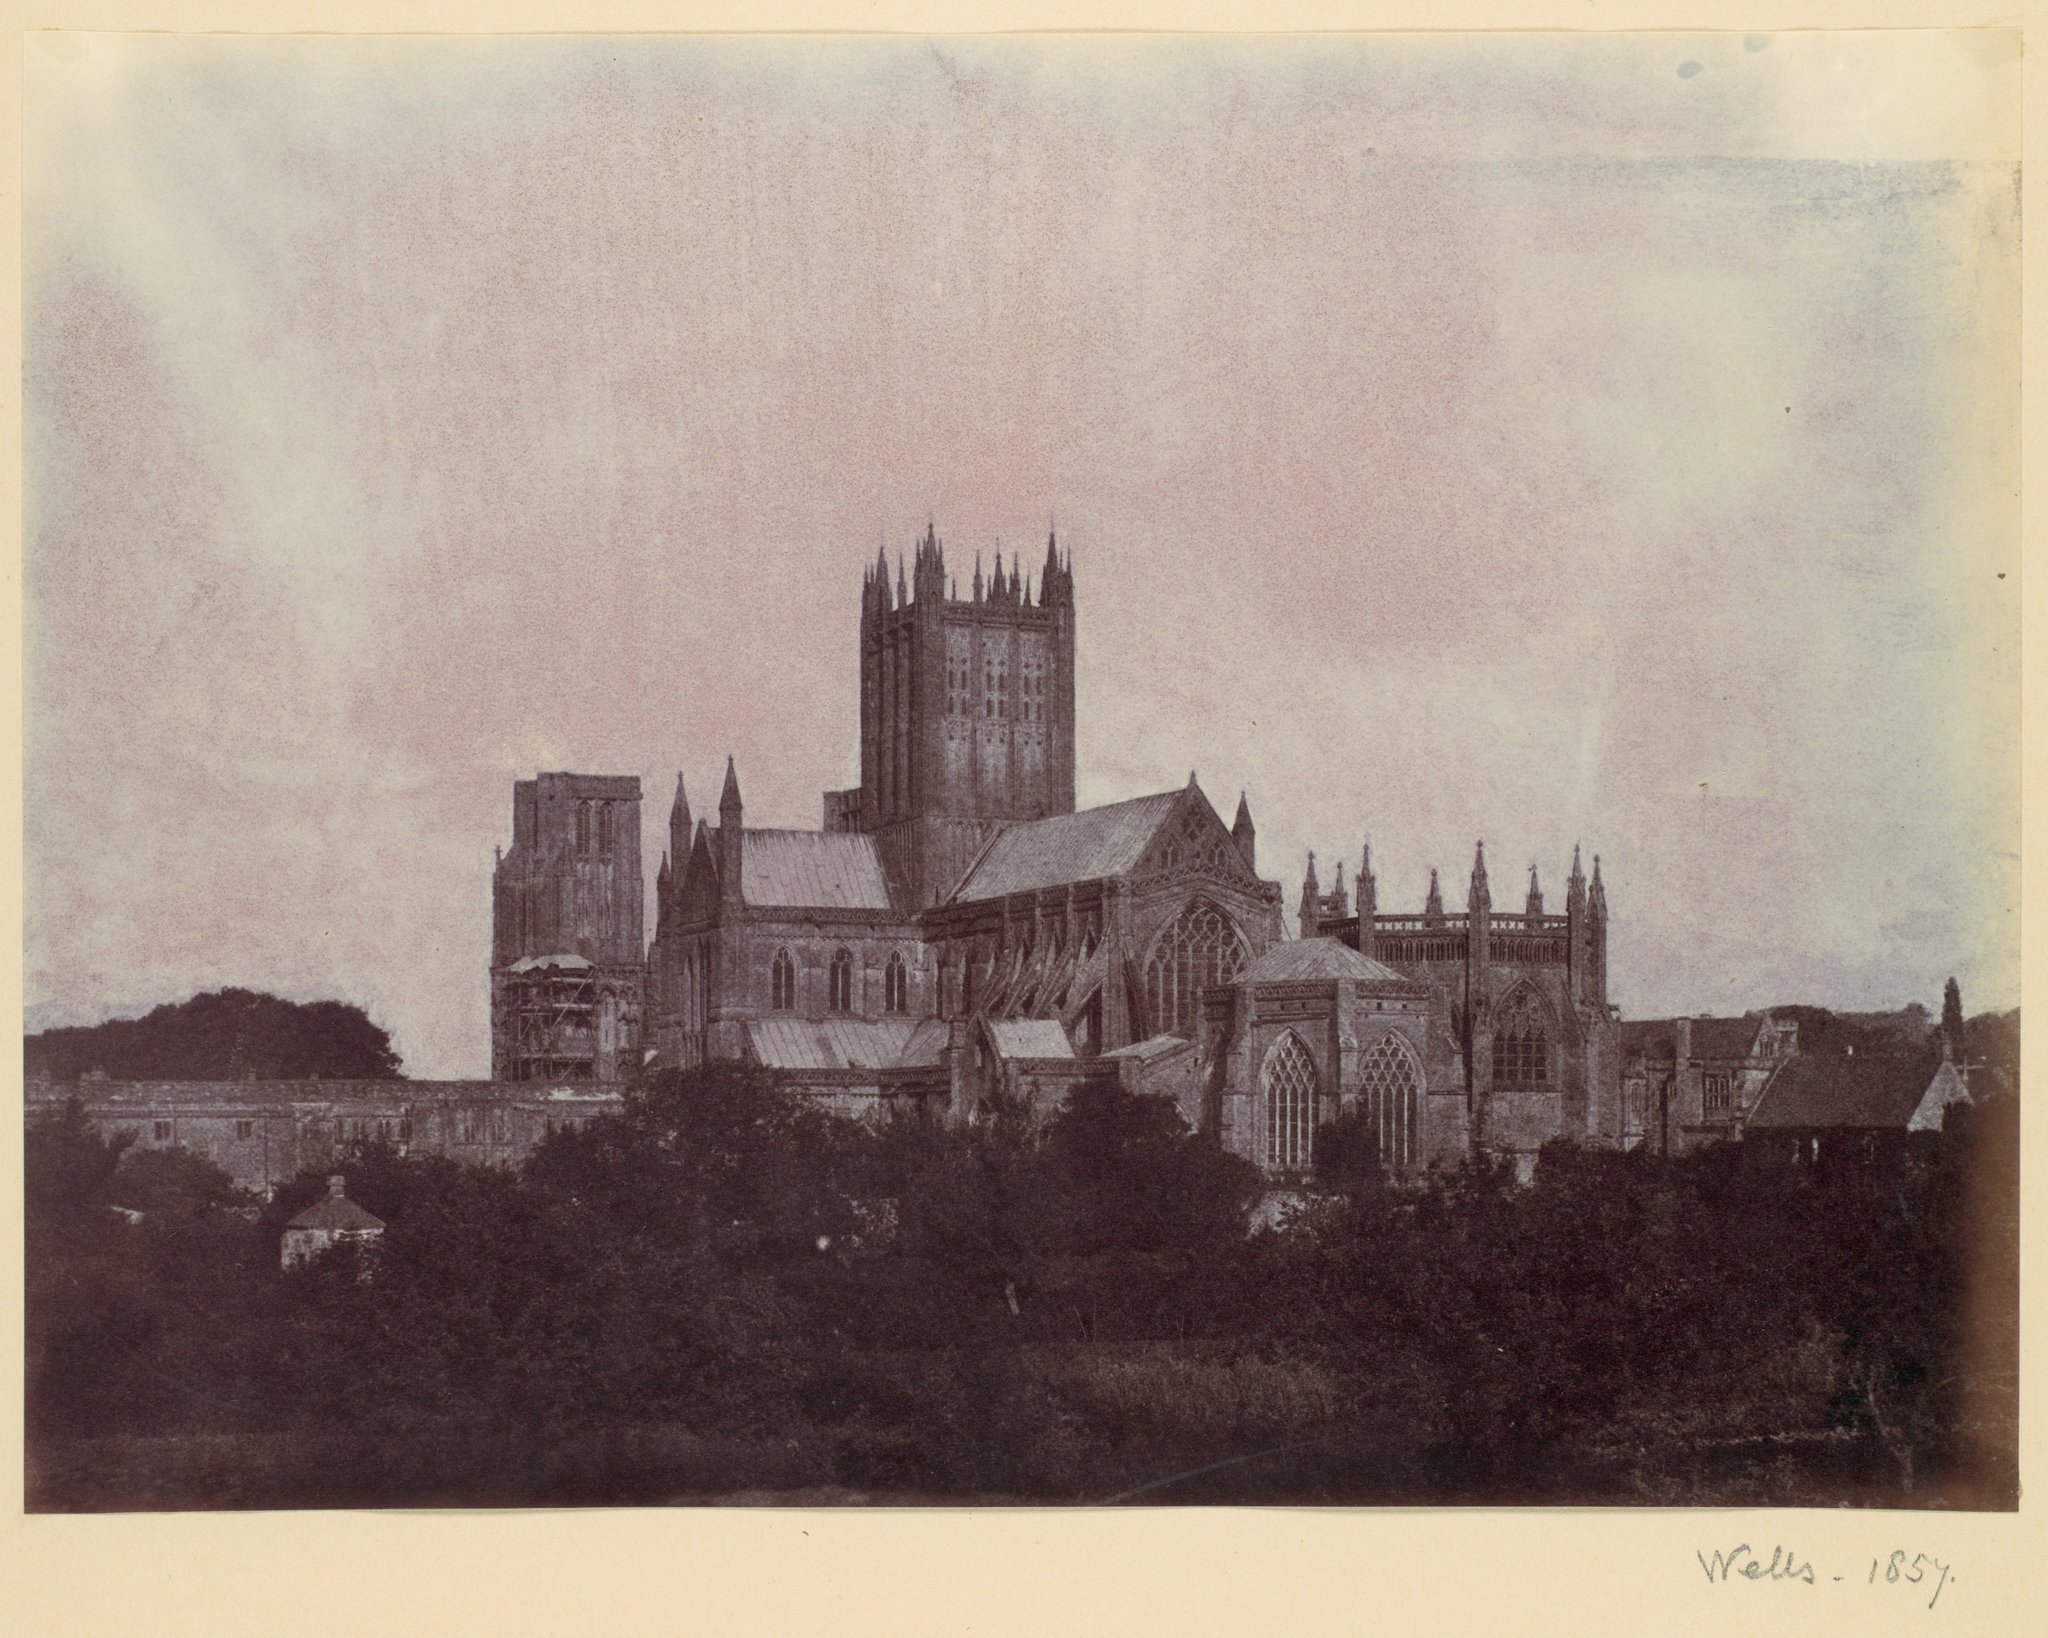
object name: photograph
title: Wells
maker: alfred capel cure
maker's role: artist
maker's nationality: british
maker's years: 1826-1896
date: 1857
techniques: albumen silver print, paper negative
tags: architecture,cathedrals